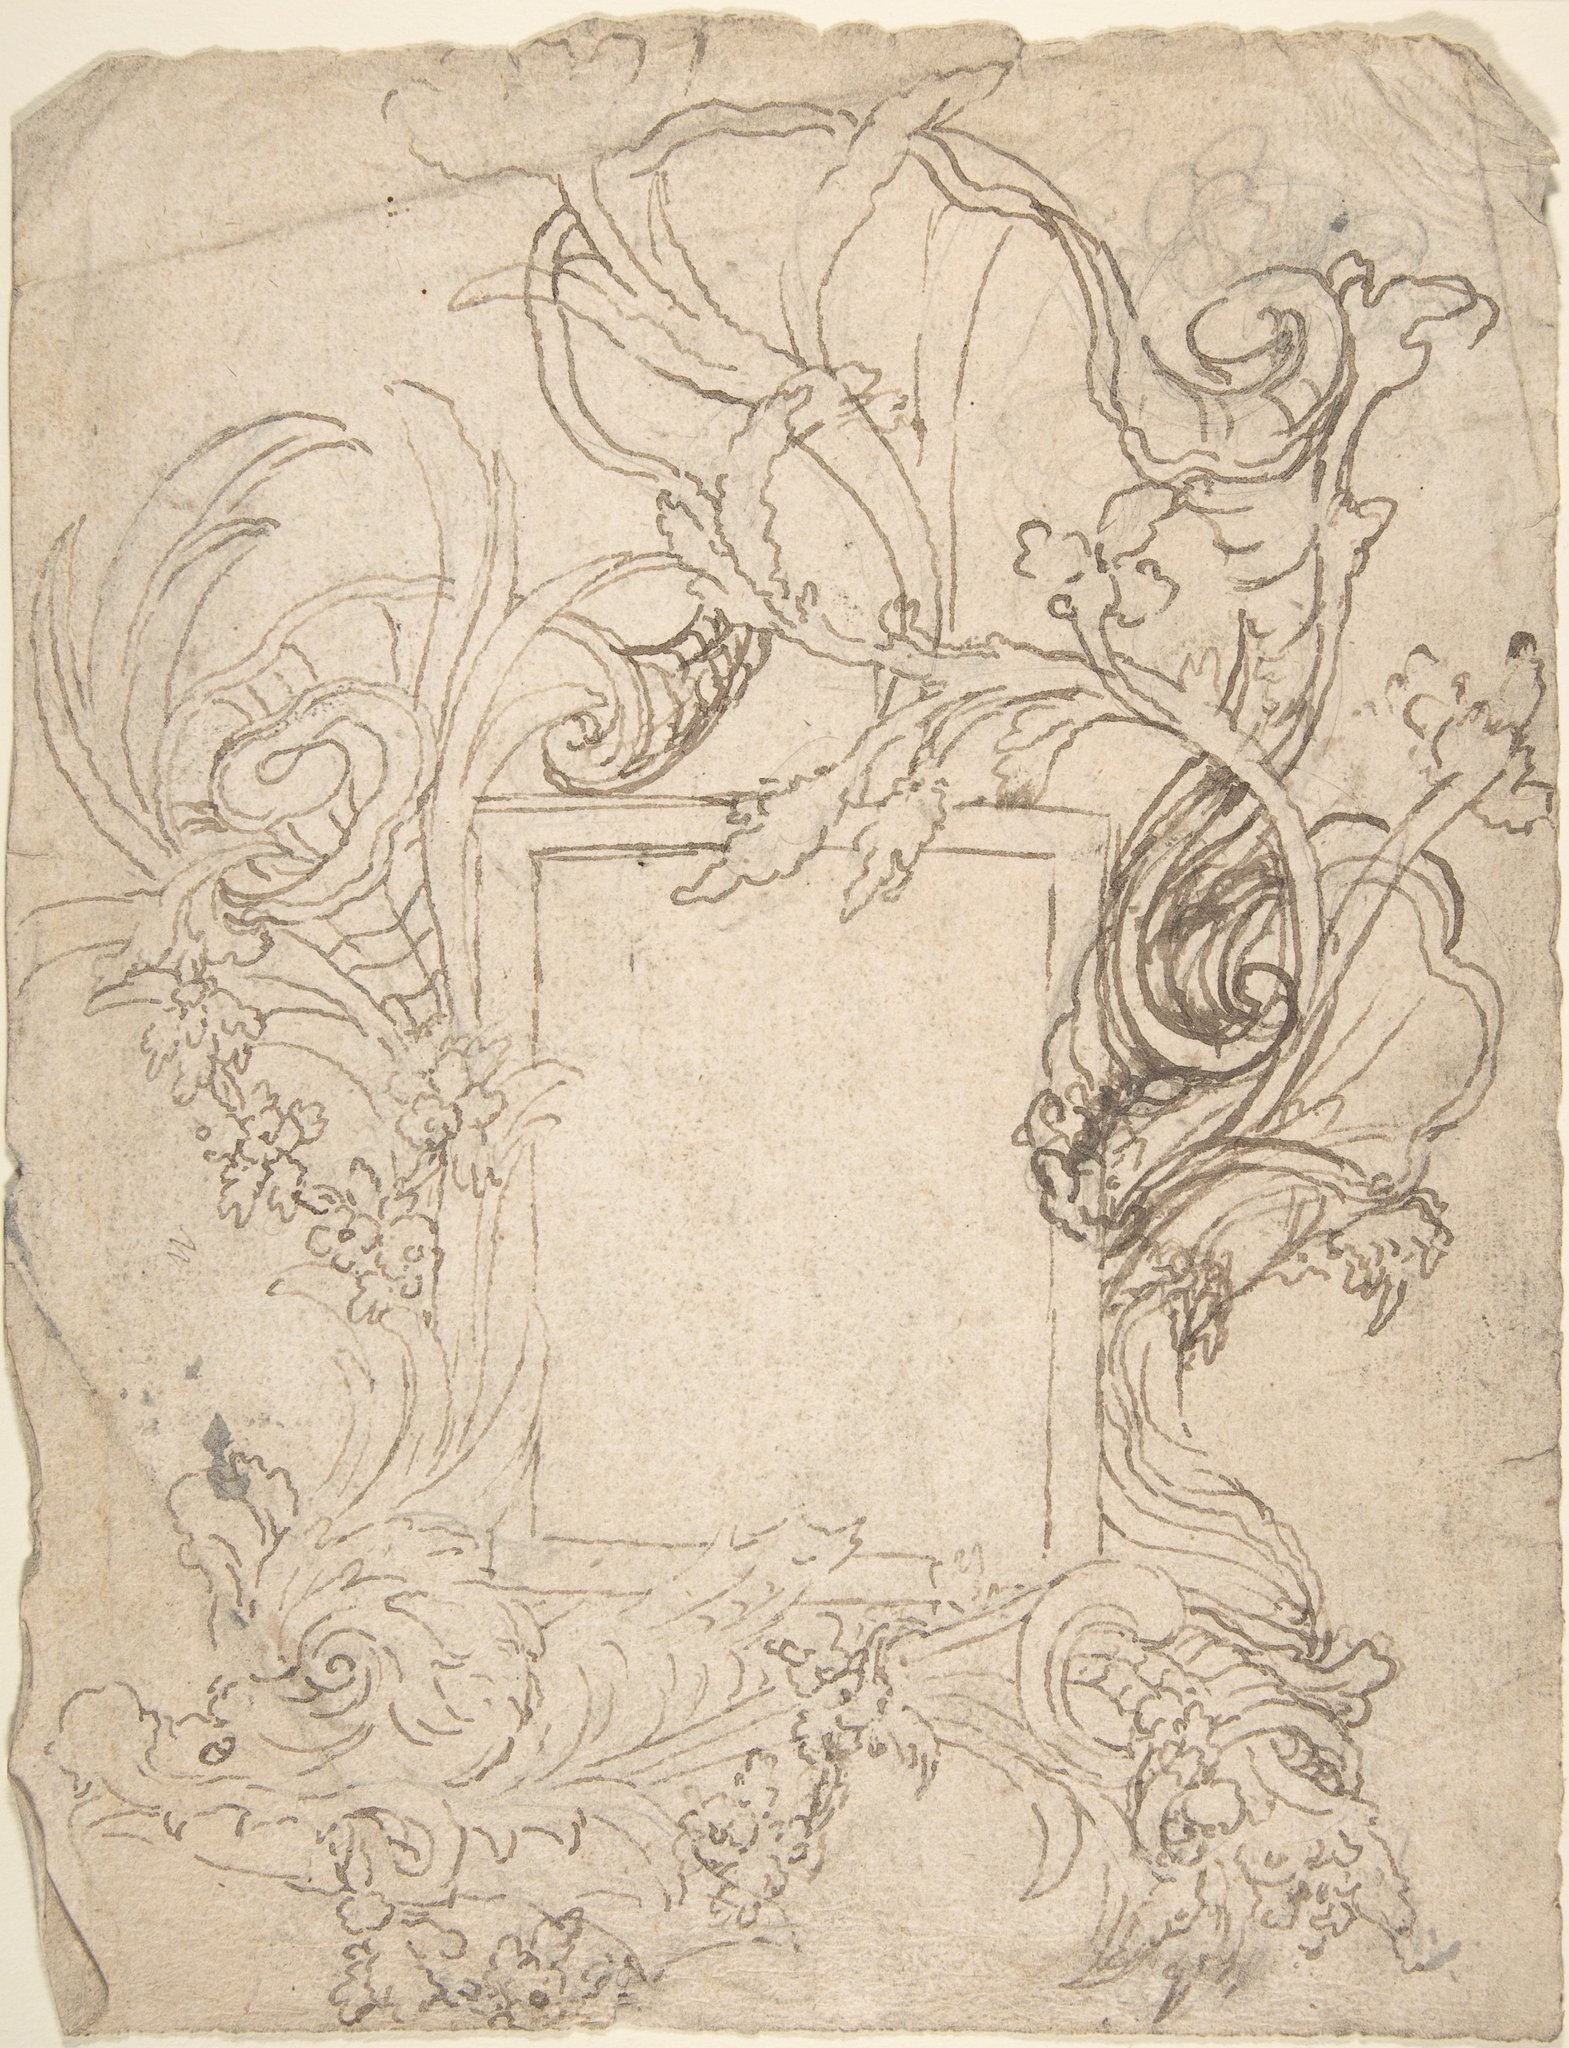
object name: drawing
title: Design for a Cartouche (recto); Design for a Cartouche (verso)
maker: anonymous, italian, 16th to early 17th century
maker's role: artist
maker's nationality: italian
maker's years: 1500-1640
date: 1580-1620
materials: chalk, ink, drawing material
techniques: pen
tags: cartouches